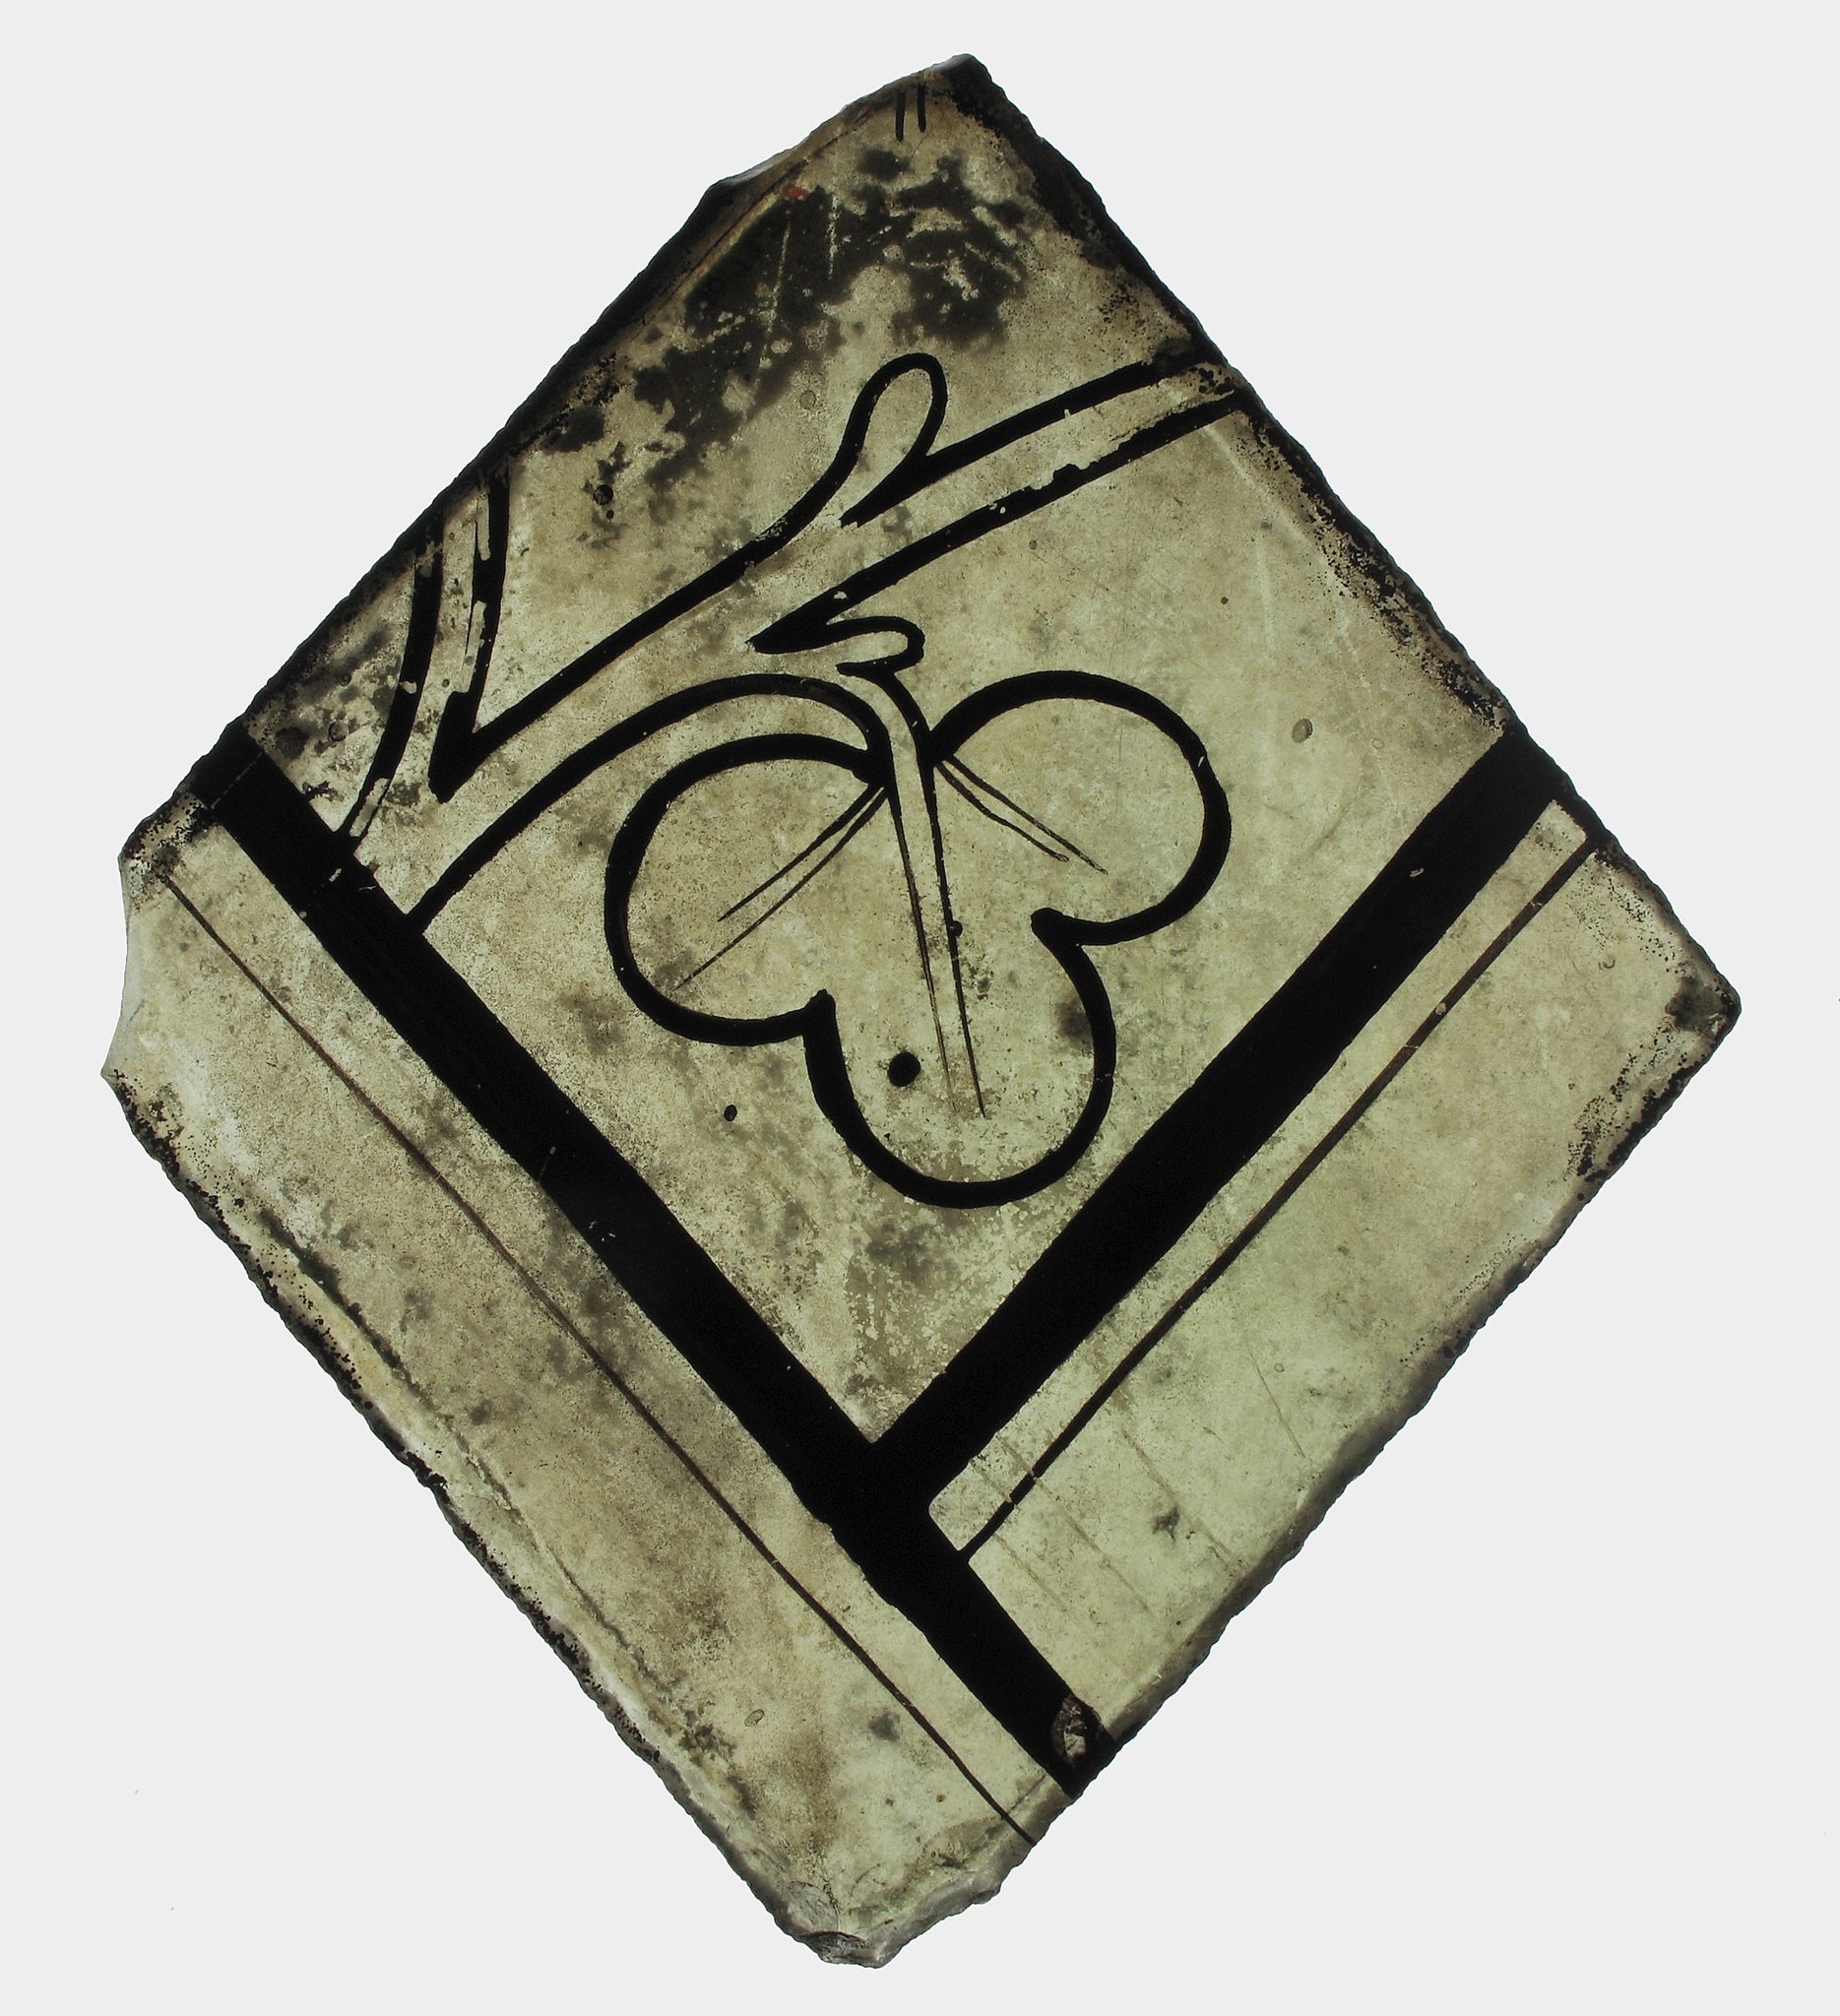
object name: fragment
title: Glass Fragment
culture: french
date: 1201-1400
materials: glass